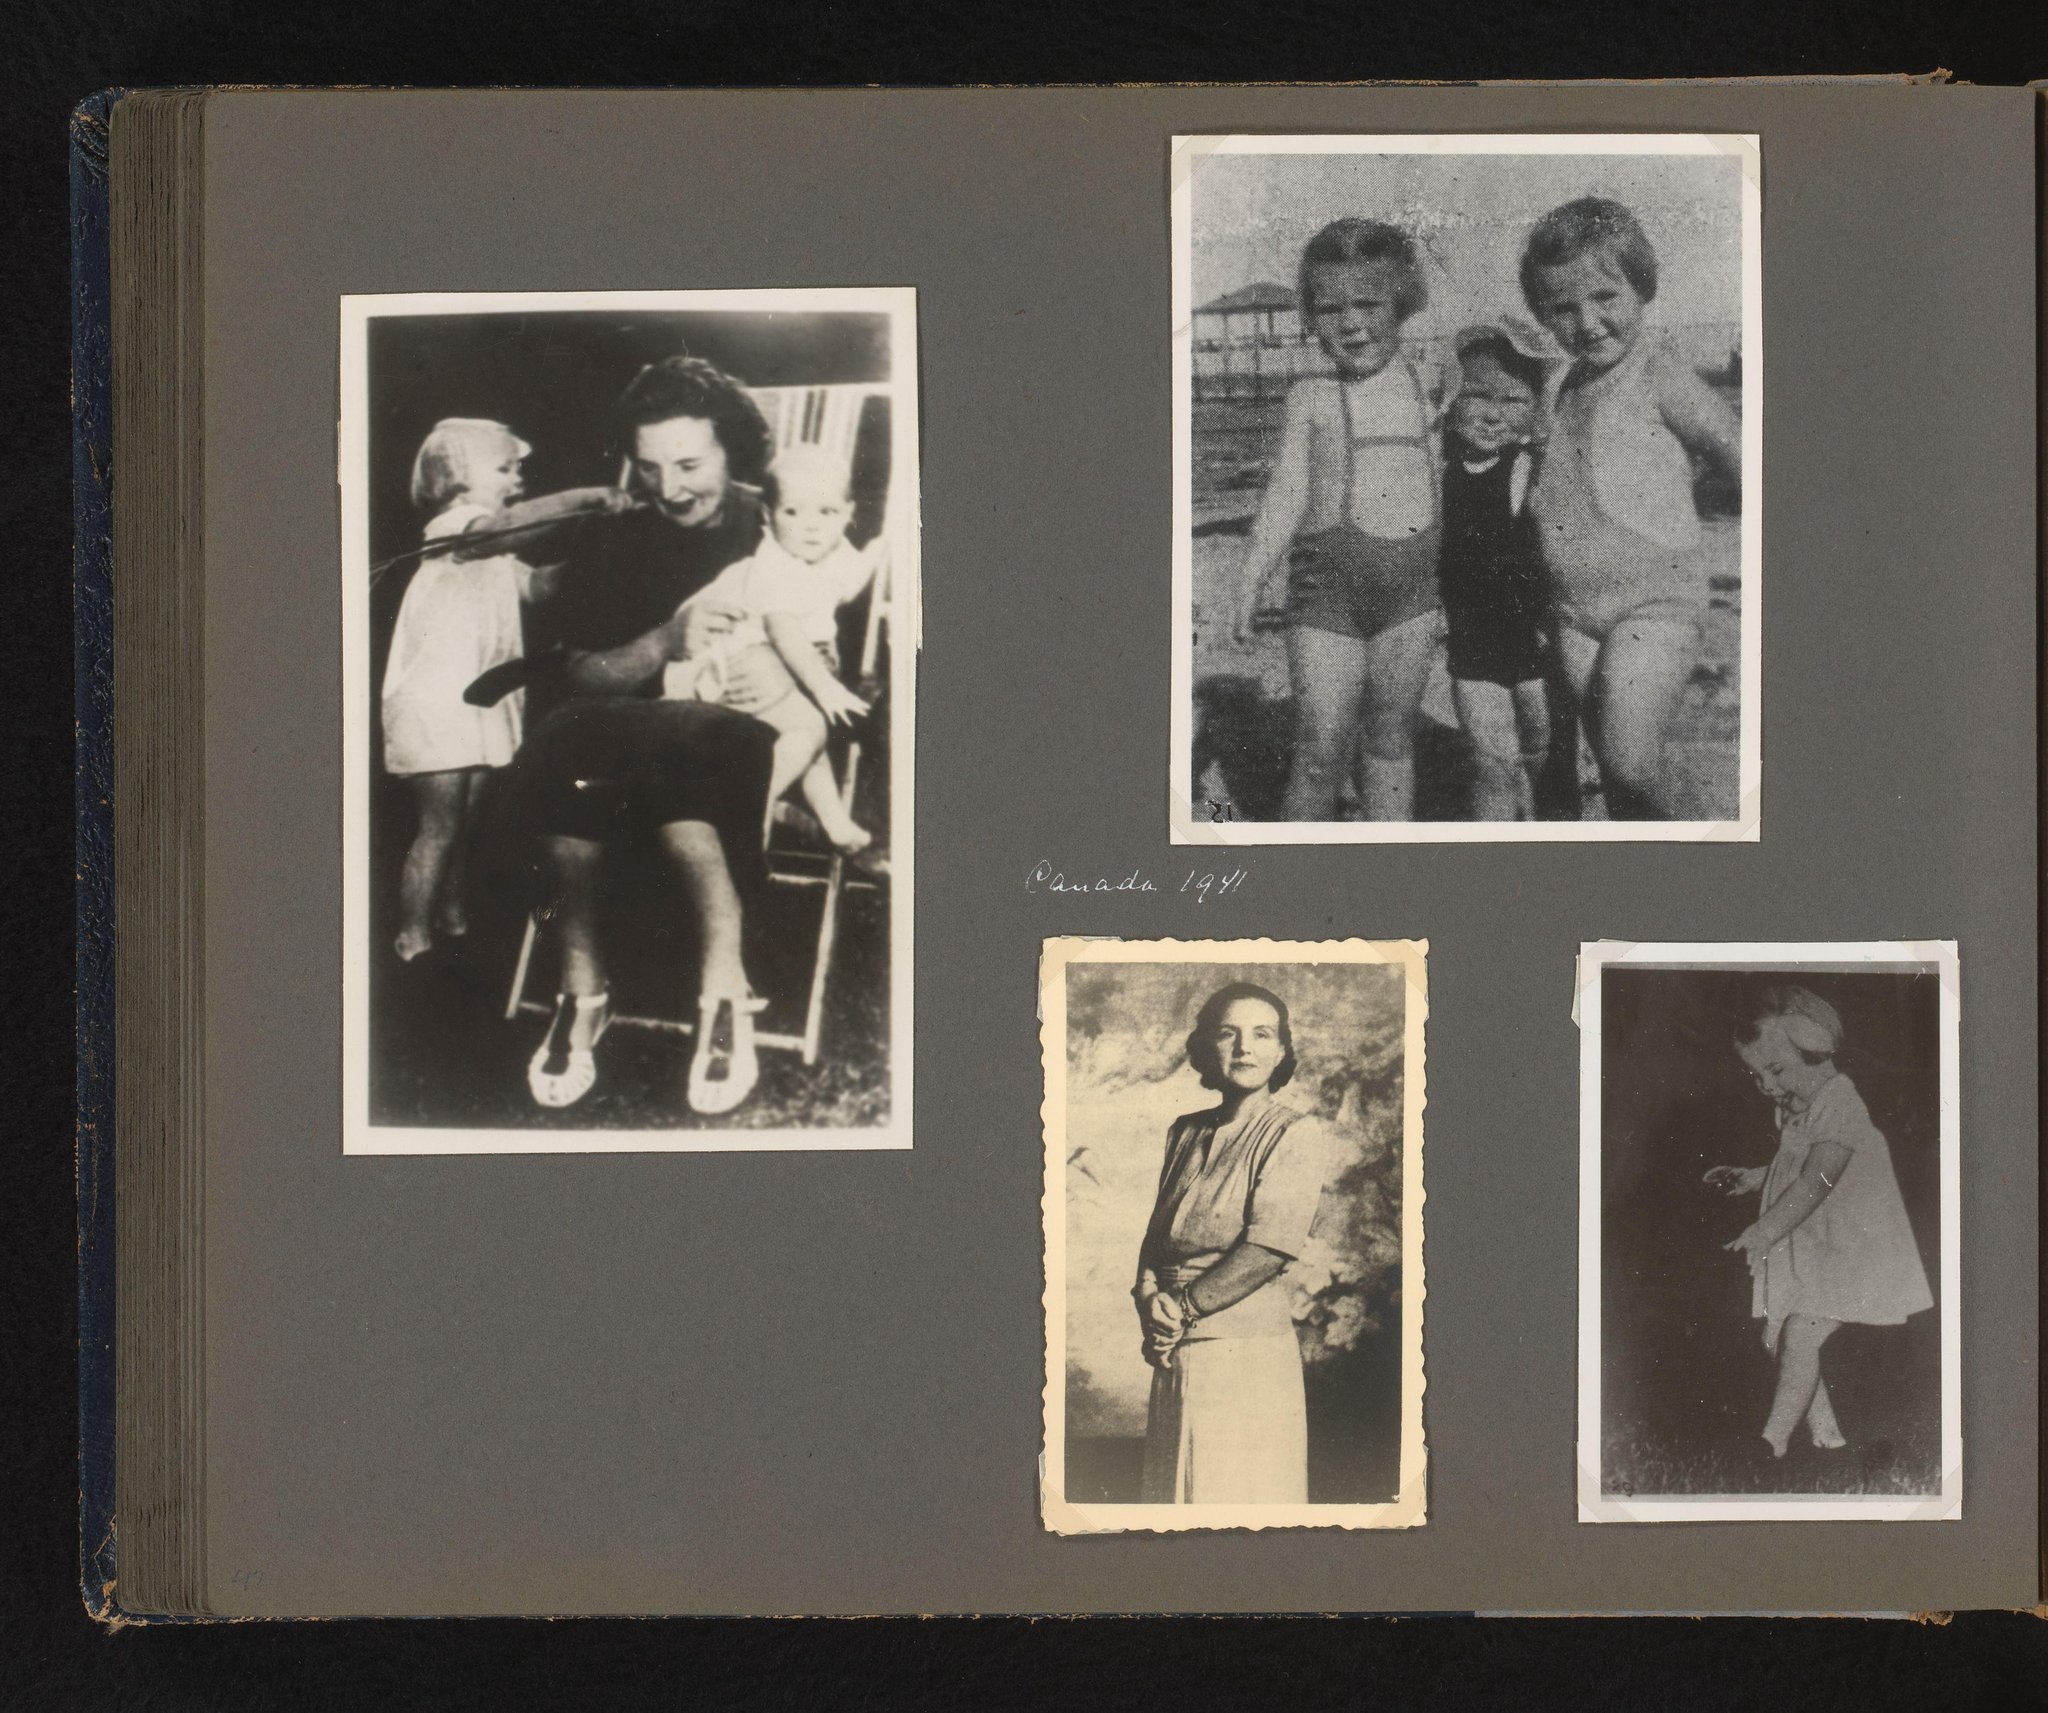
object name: photograph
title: Prinses Juliana met de prinsesjes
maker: Anonymous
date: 1941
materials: cardboard, photographic support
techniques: gelatin silver print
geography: canada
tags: beatrix (koningin der nederlanden), the hague, juliana of the netherlands, parents with their children, canada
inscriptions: inscription: ‘Canada 1941’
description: Albumblad met vier foto's van prinses Juliana met de prinsessen Beatrix en Irene in Canada, 1941. Onderdeel van fotoalbum over het familieleven van de leden van het Koninklijk Huis tussen 1937-1945.